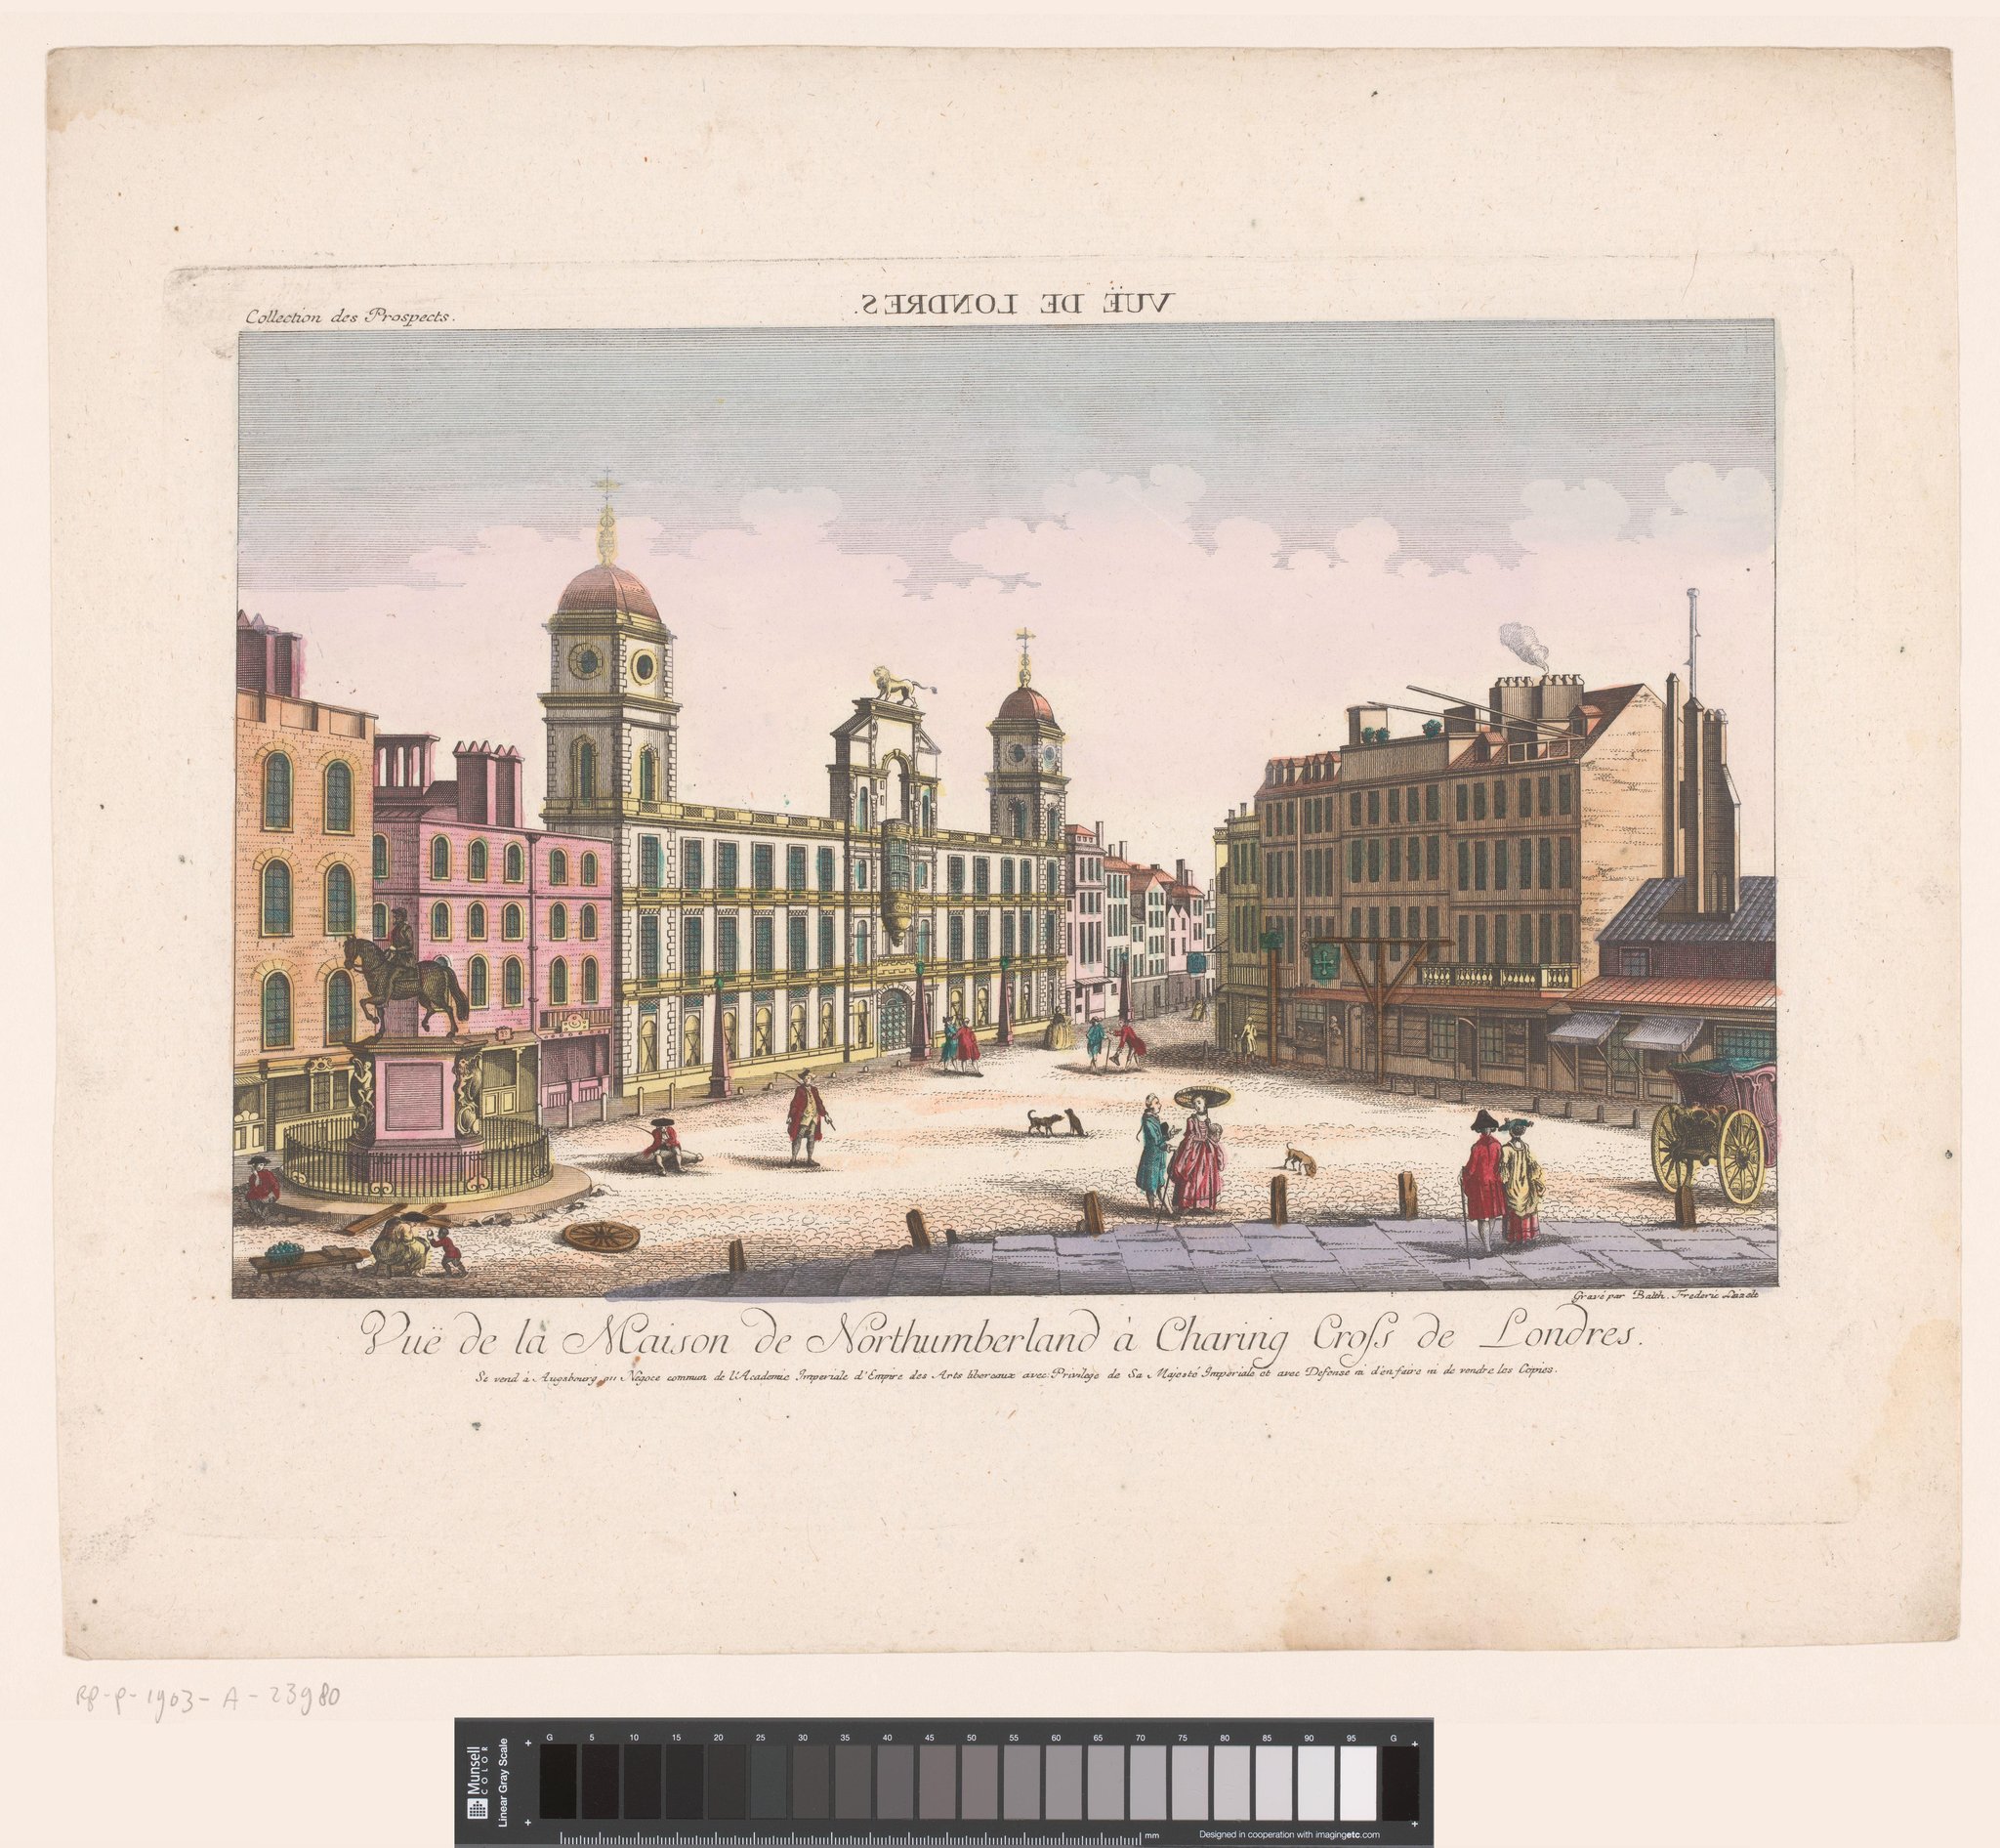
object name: print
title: Vuë de la Maison de Northumberland à Charing Cross de Londres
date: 1755-1779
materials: paper, watercolor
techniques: brush, etching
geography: augsburg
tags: city-view in general; 'veduta', monumental adornments (in city)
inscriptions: collector's mark: Lugt 2228